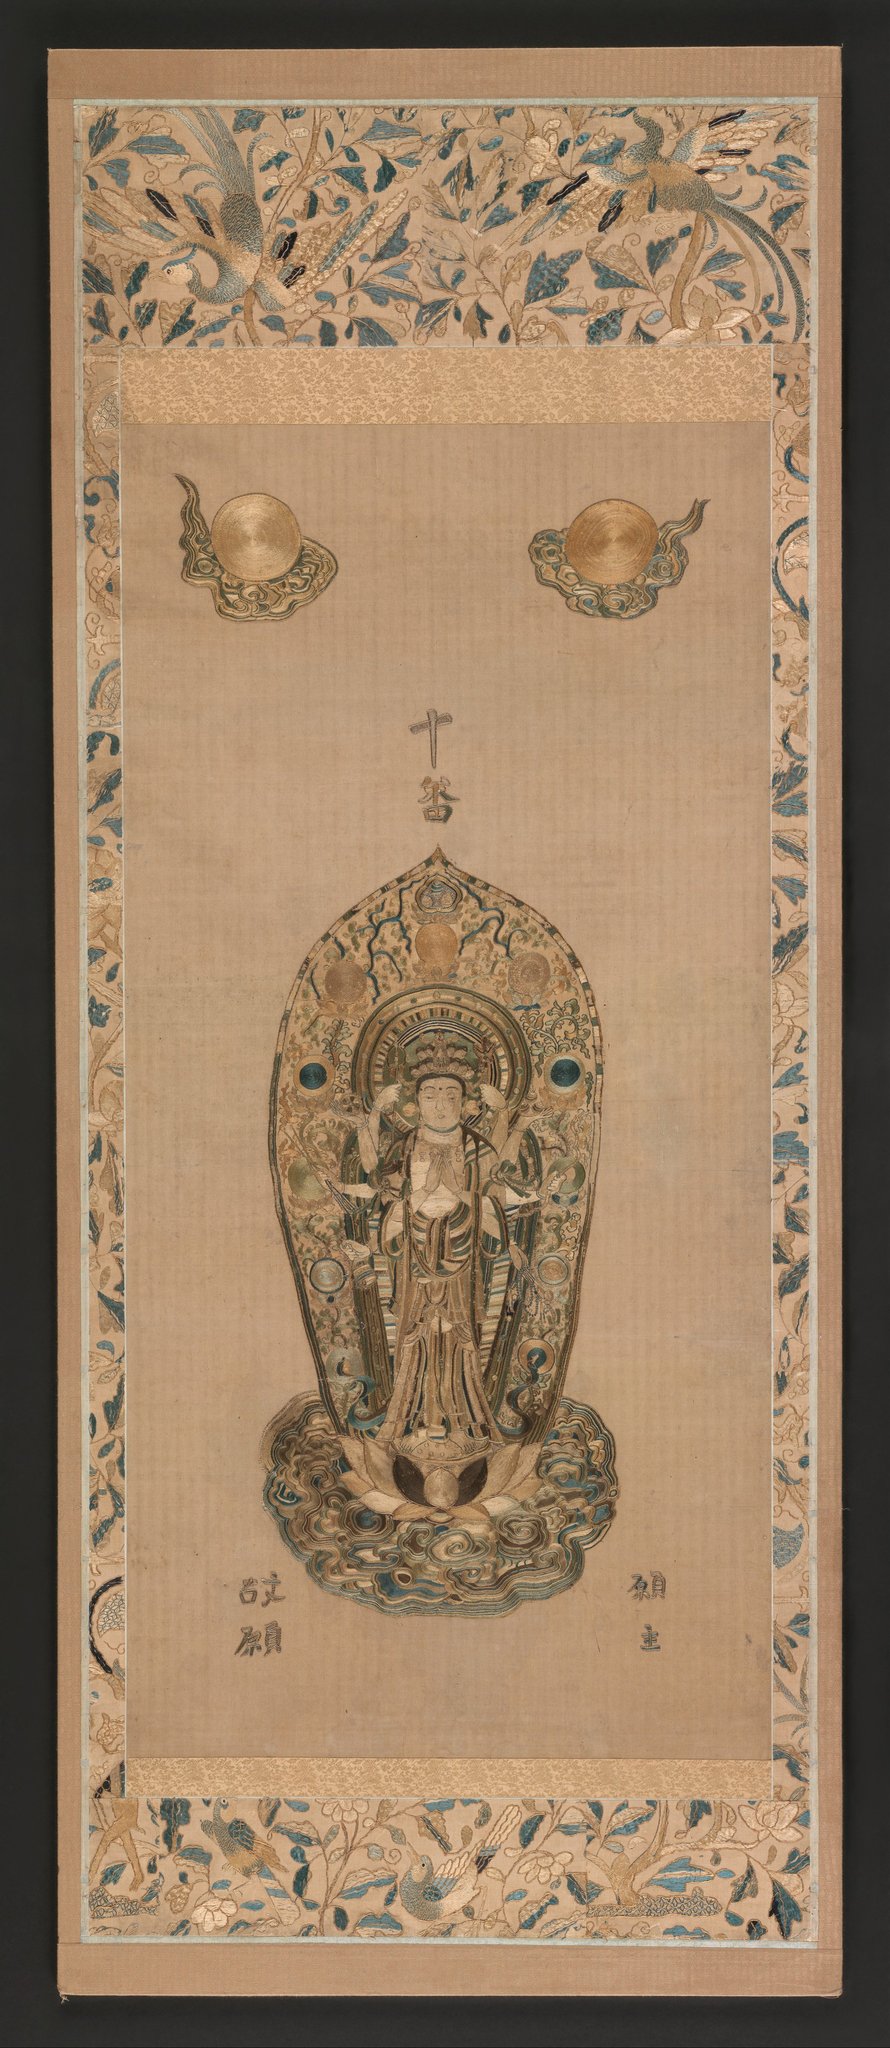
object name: hanging scroll mounted a panel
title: Embroidery of a Thousand-Armed Kannon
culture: japanese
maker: unidentified artist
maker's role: artist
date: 1467-1533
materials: cotton, panel, silk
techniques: embroidery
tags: buddhism,bodhisattvas